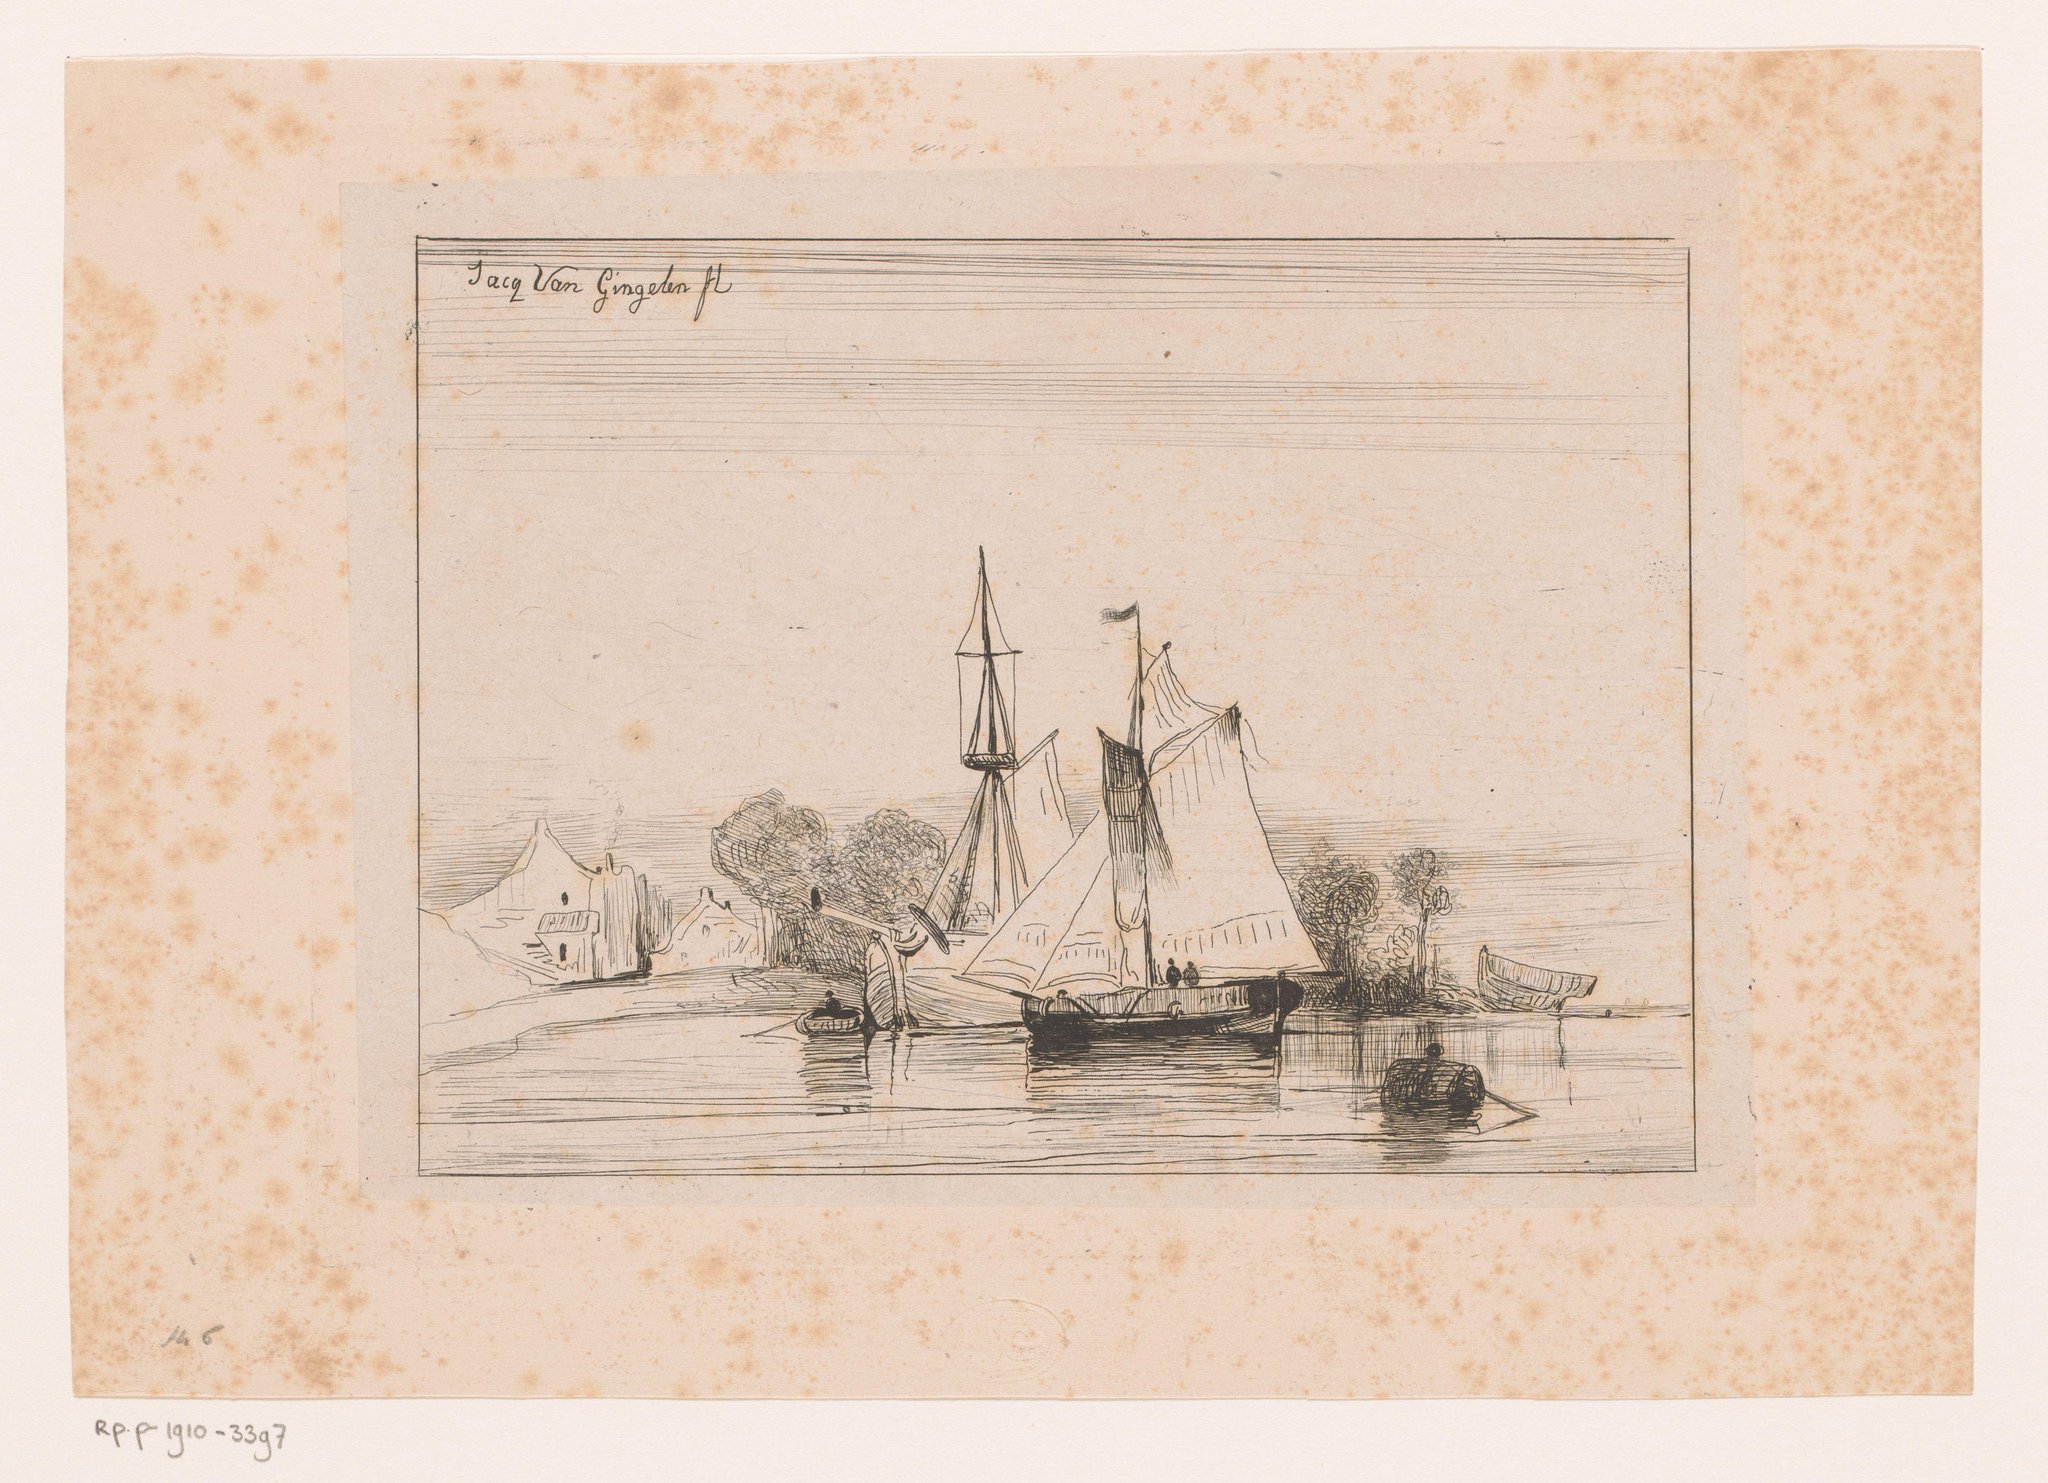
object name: print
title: Twee zeilschepen in het water bij een dorp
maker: jacques van gingelen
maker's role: print maker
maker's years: 1801-1864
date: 1811-1864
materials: paper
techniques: etching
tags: sailing-ship, sailing-boat, village, ship bound for the harbour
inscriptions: mark: ‘JVG’, collector's mark: Lugt 2228